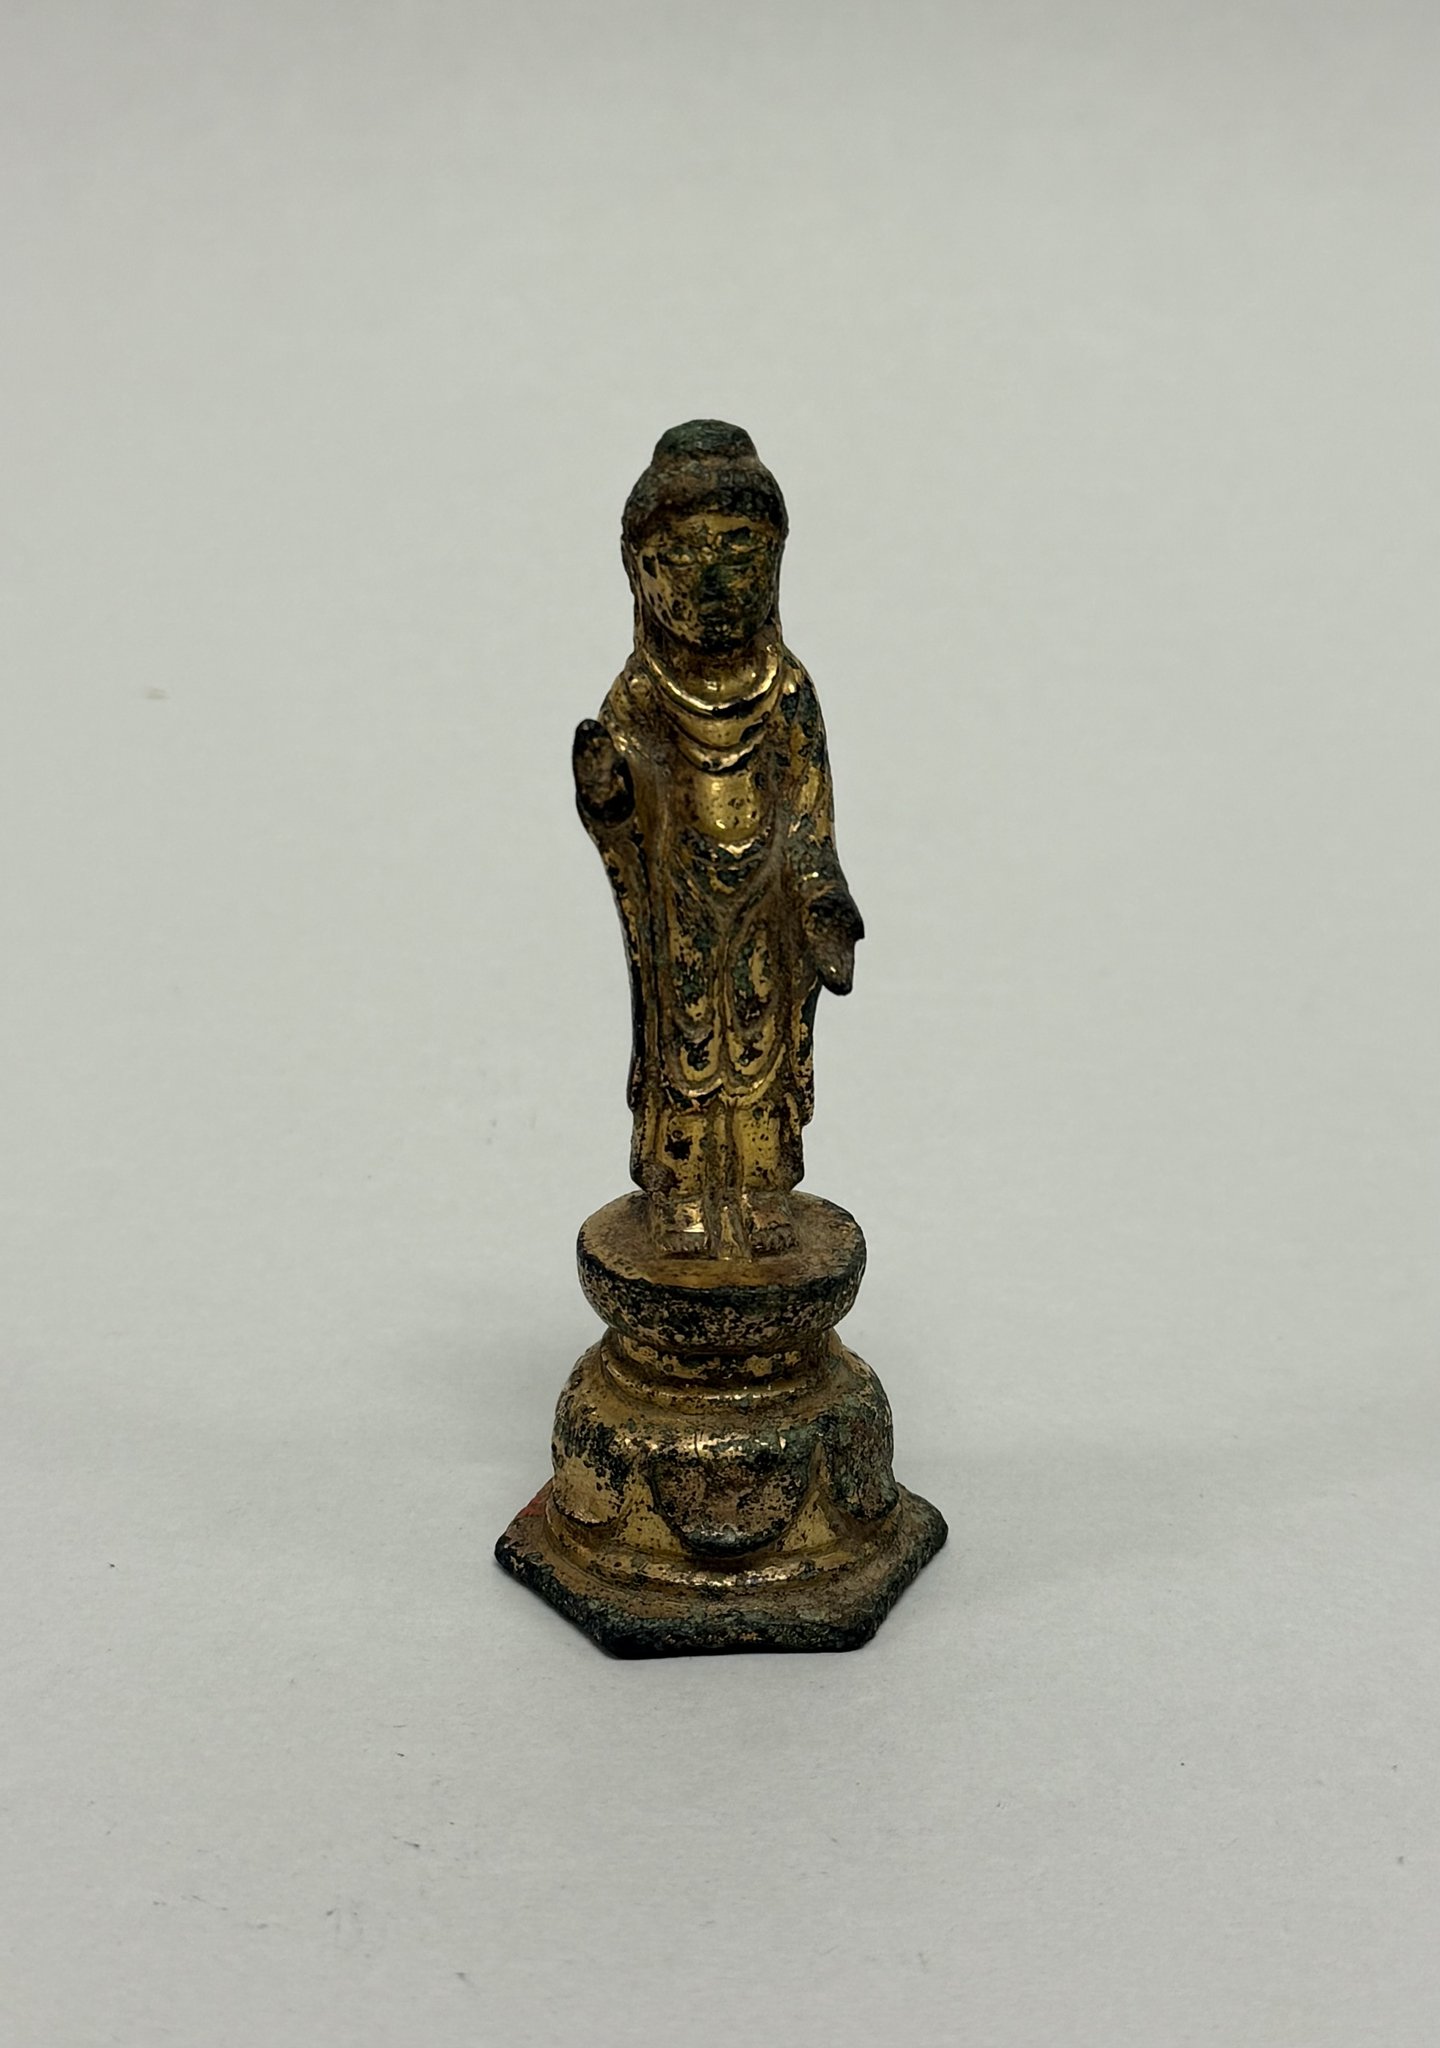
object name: statuette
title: Buddha on Lotus Throne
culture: korean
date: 601-800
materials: gilt bronze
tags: buddhism,buddha